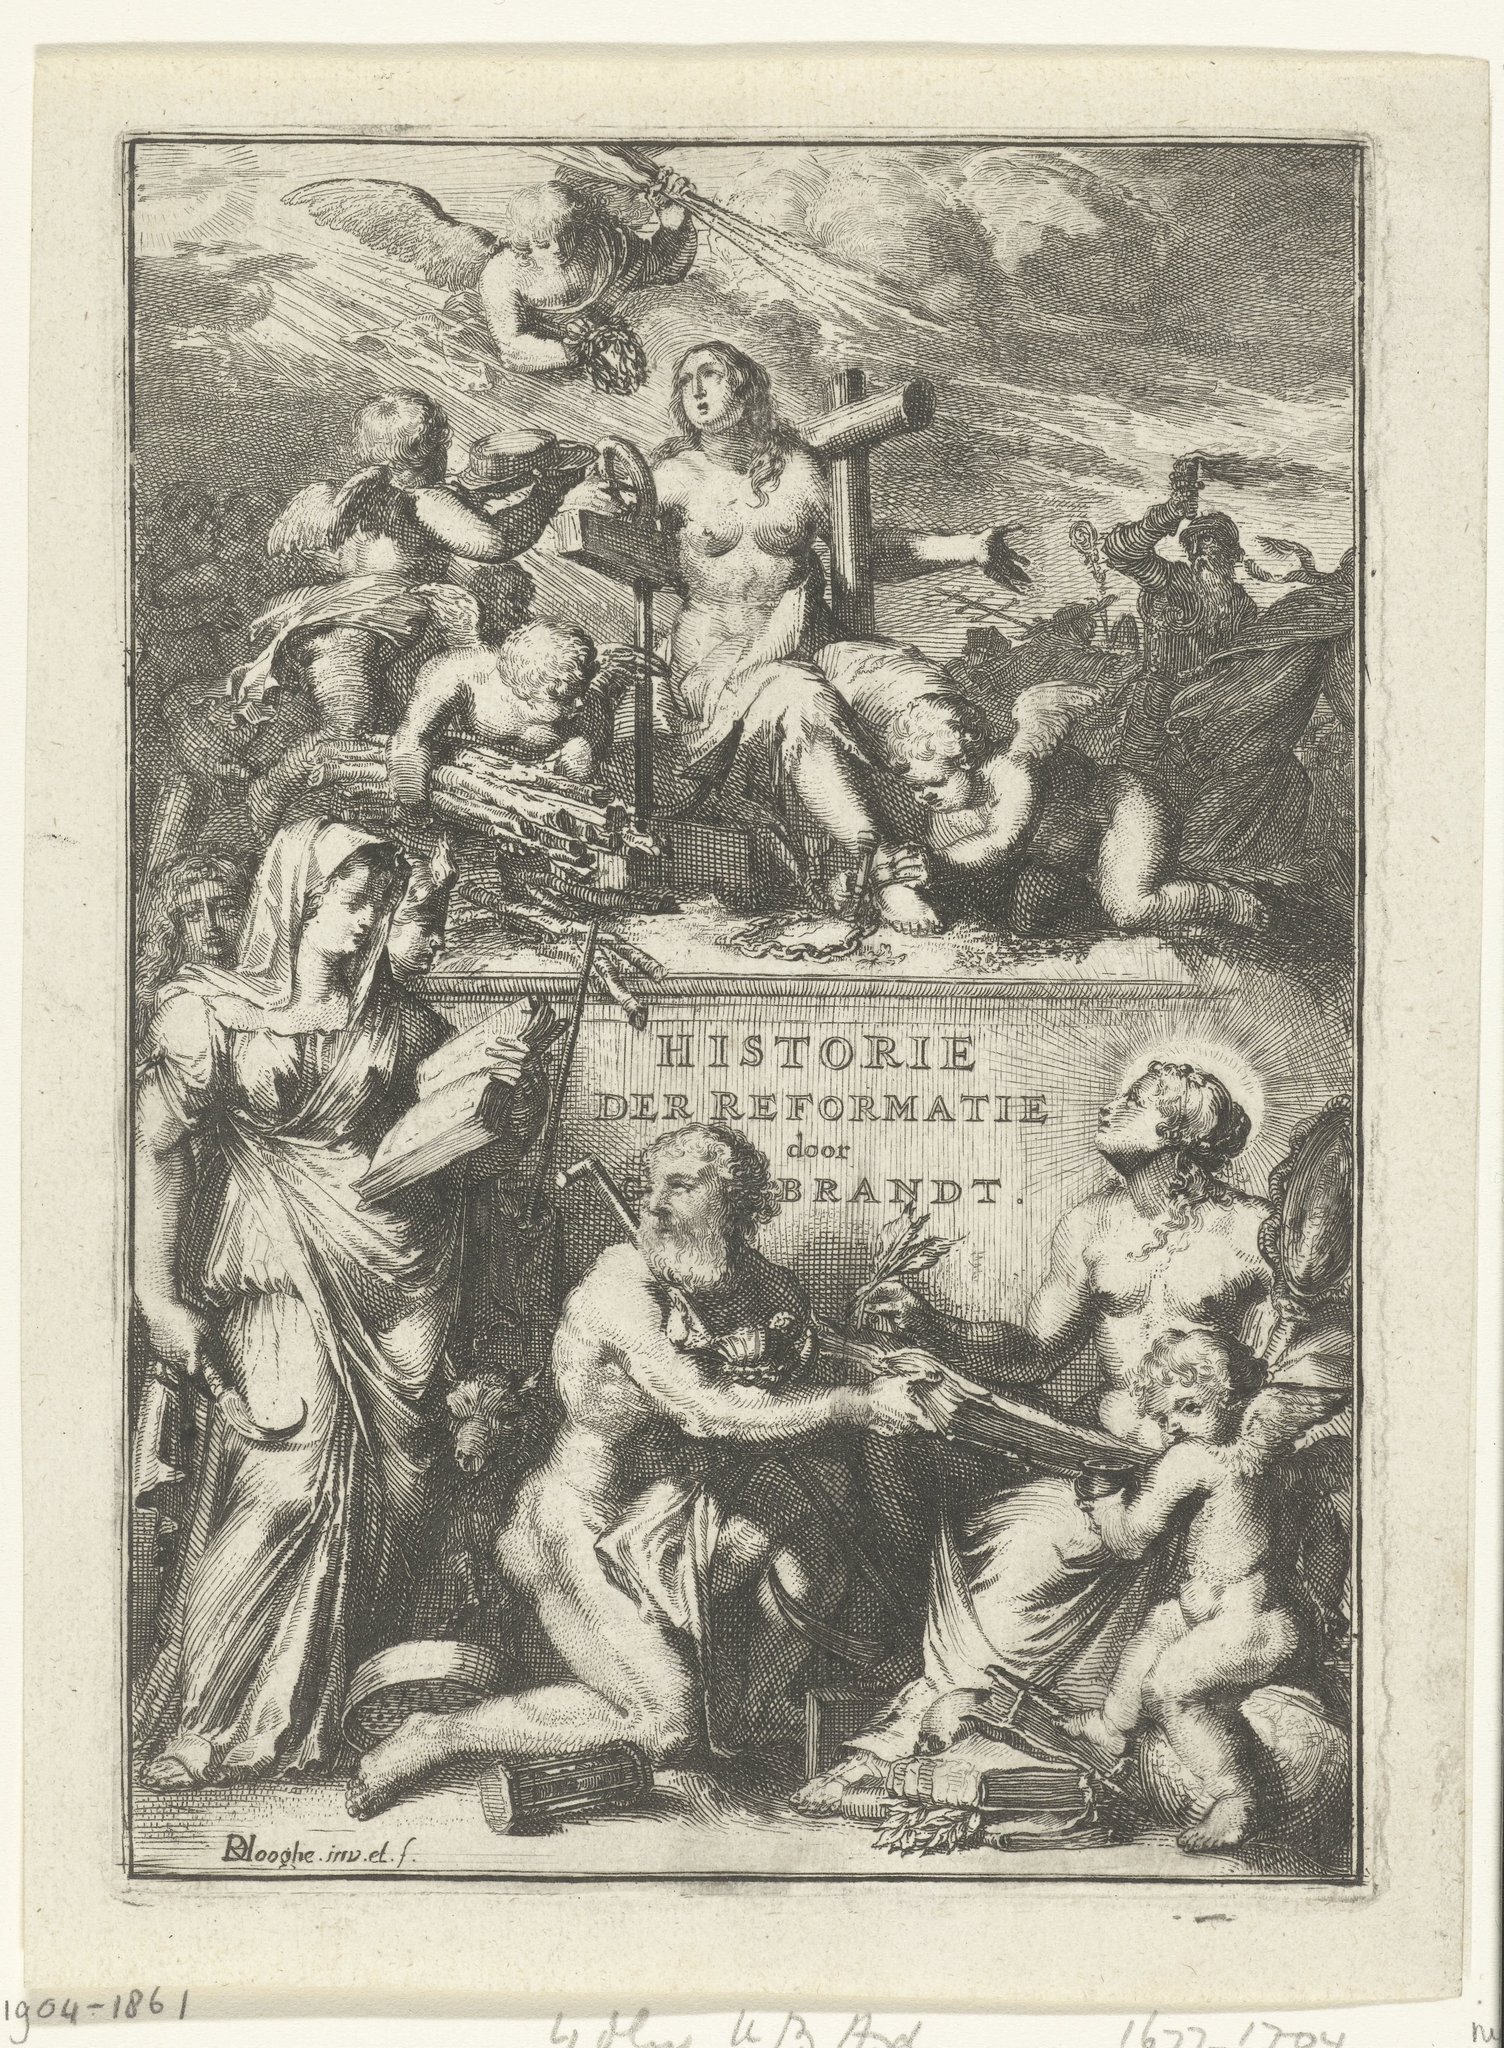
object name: print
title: Historie der Reformatie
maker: romeyn de hooghe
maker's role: draughtsman, goldsmith, painter, print maker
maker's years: 1645-1708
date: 1671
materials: paper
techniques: etching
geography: amsterdam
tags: the three theological virtues, cupids: 'amores', 'amoretti', 'putti'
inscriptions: collector's mark: Lugt 2228a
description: Op een verhoging zit een halfnaakte vrouw met een kruis en een anker. Om haar heen zijn een aantal putti in de weer met een vrijheidshoed, brandhout en boeien. Voor de verhoging nog een aantal allegorische figuren.